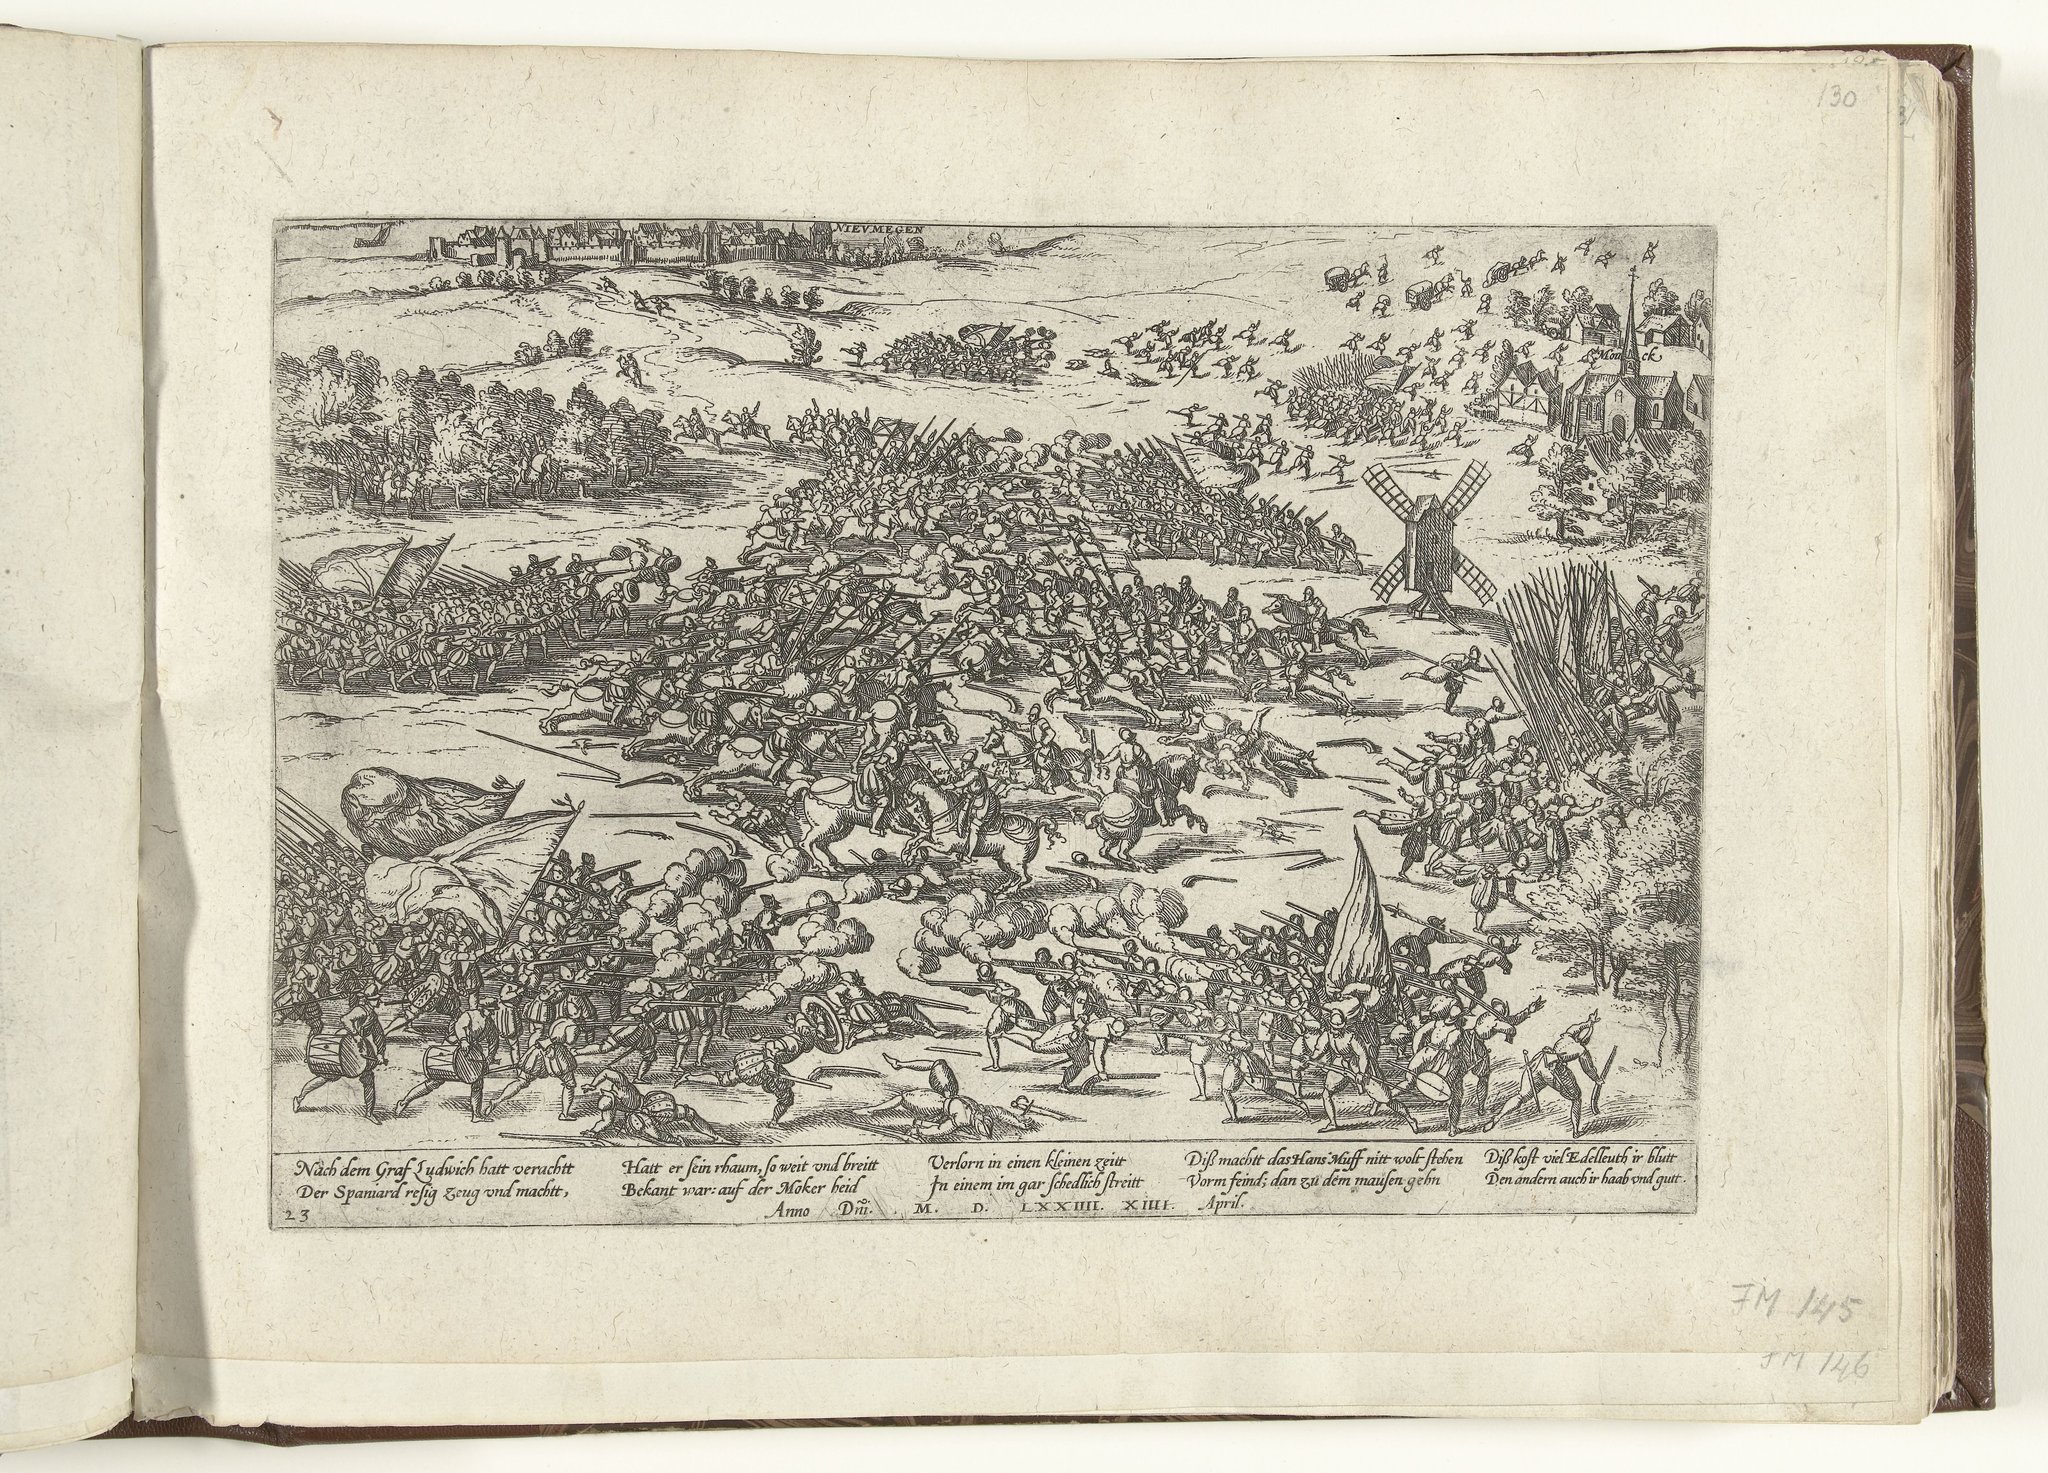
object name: print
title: Slag op de Mookerheide, 1574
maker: frans hogenberg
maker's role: print maker, publisher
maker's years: 1538-1590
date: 1574-1576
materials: paper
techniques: etching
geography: cologne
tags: battle (+ land forces), nijmegen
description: Slag op de Mookerheide, 14 april 1574. Veldslag tussen het leger van de opstandelingen onder bevel van Lodewijk en Hendrik van Nassau en het Spaanse leger onder de veldheren d'Avila, Mendoza en Mondragon. Linksboven Nijmegen, rechts Mook. Met onderschrift van 10 regels in het Duits. Genummerd: 23.